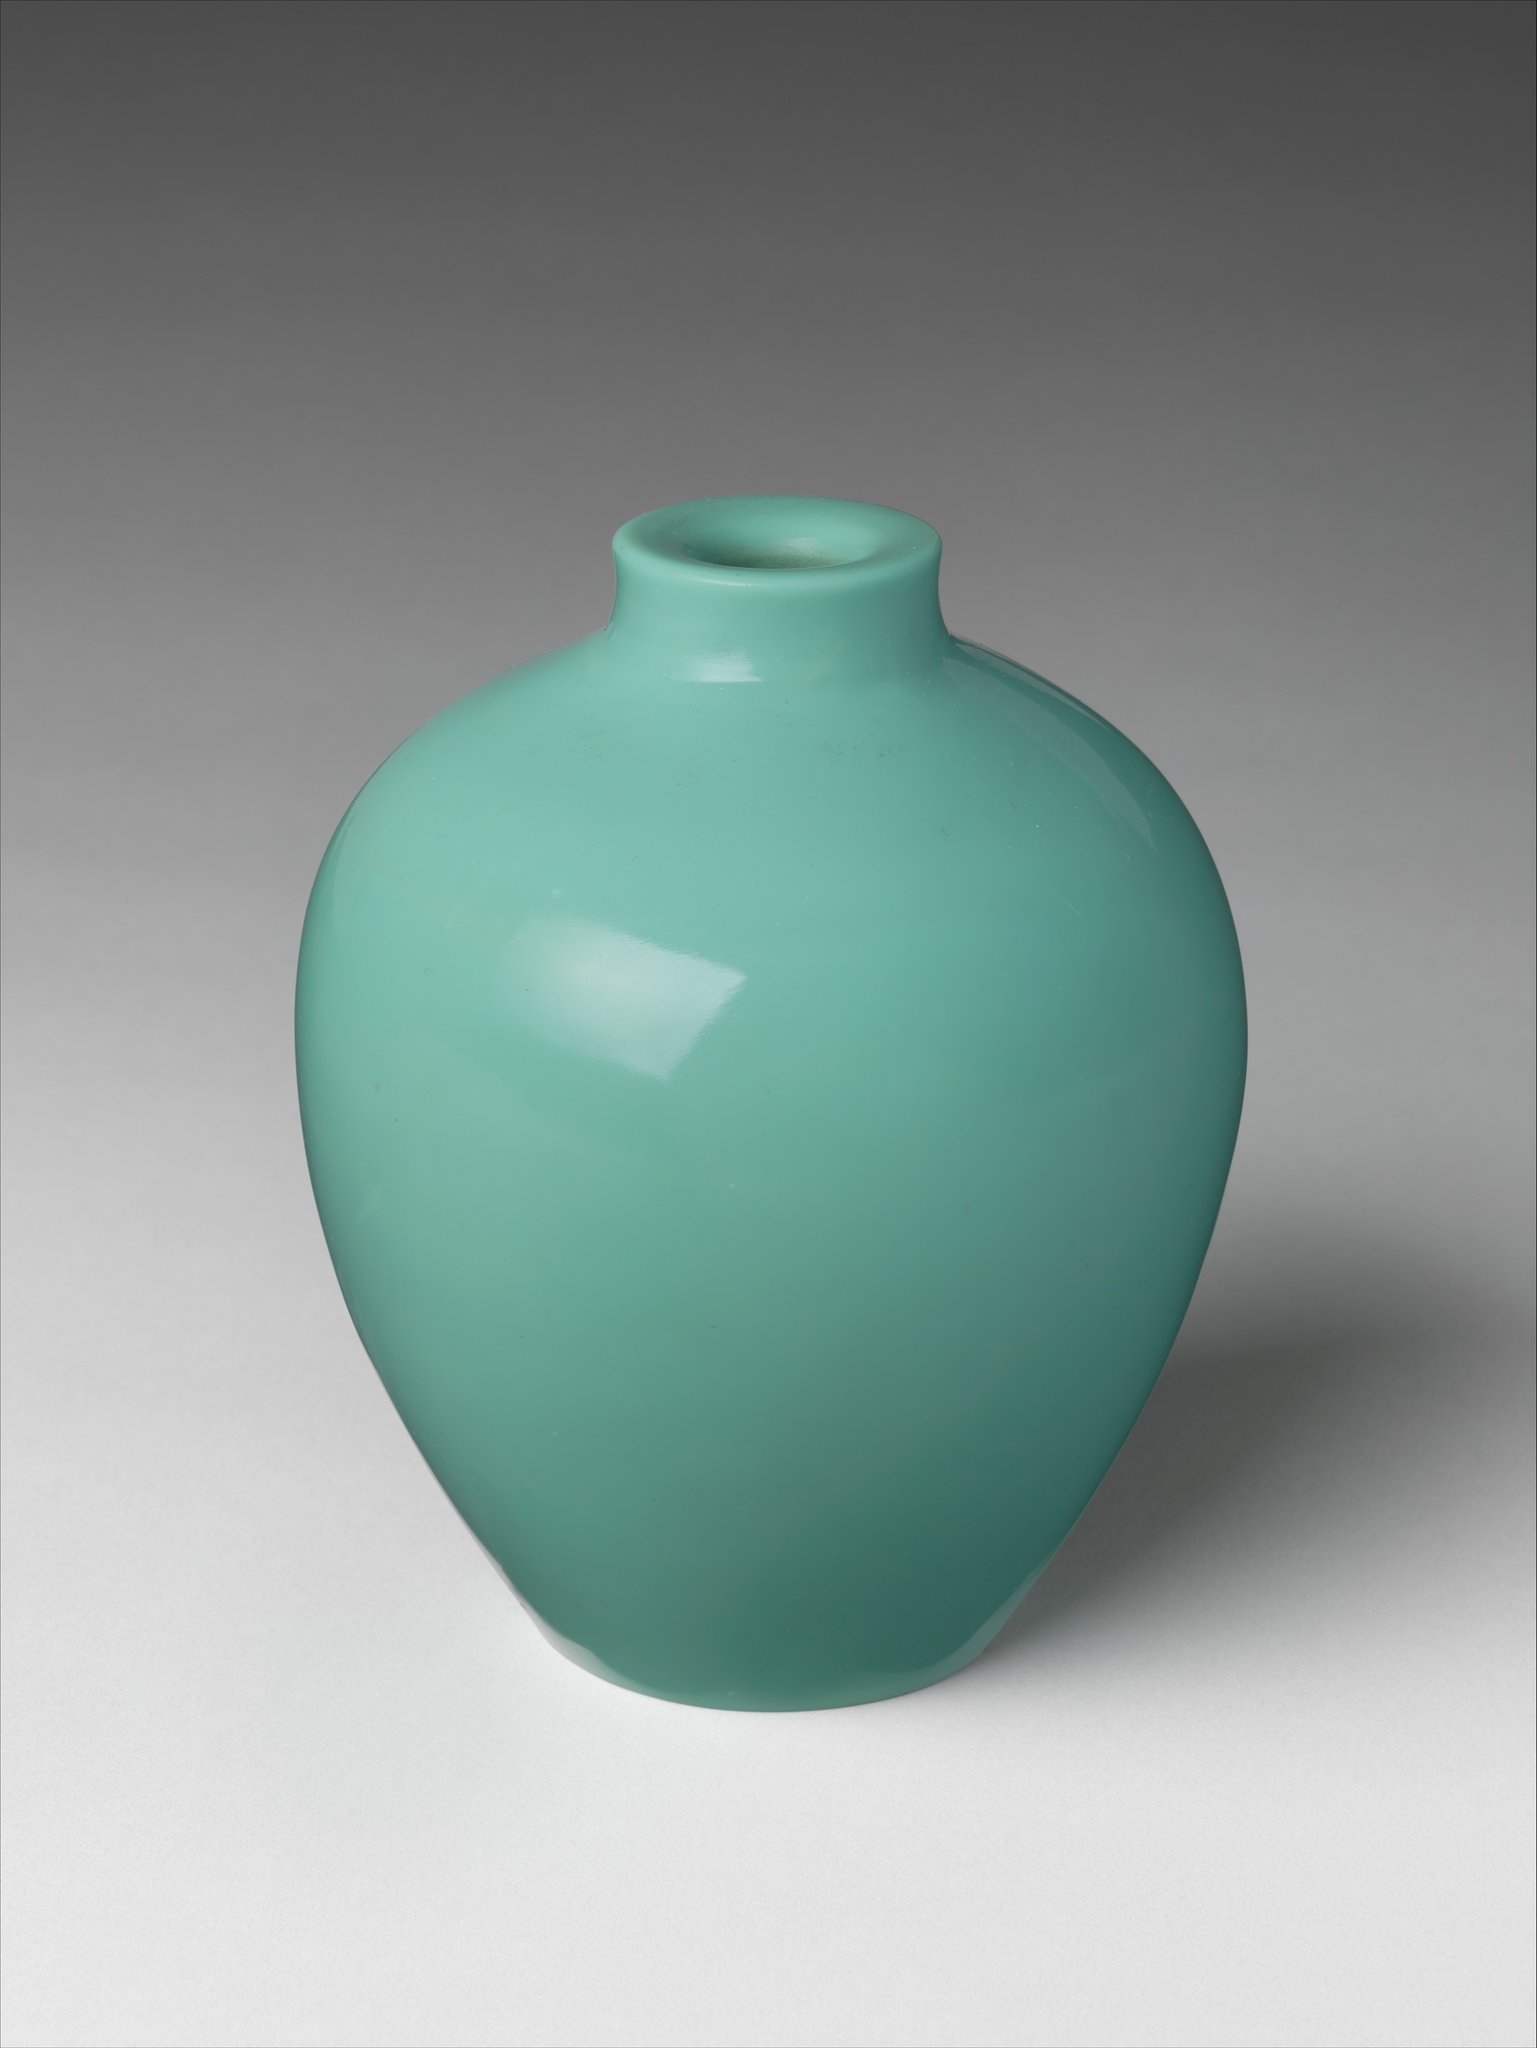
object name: vase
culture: chinese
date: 1734-1766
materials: glass